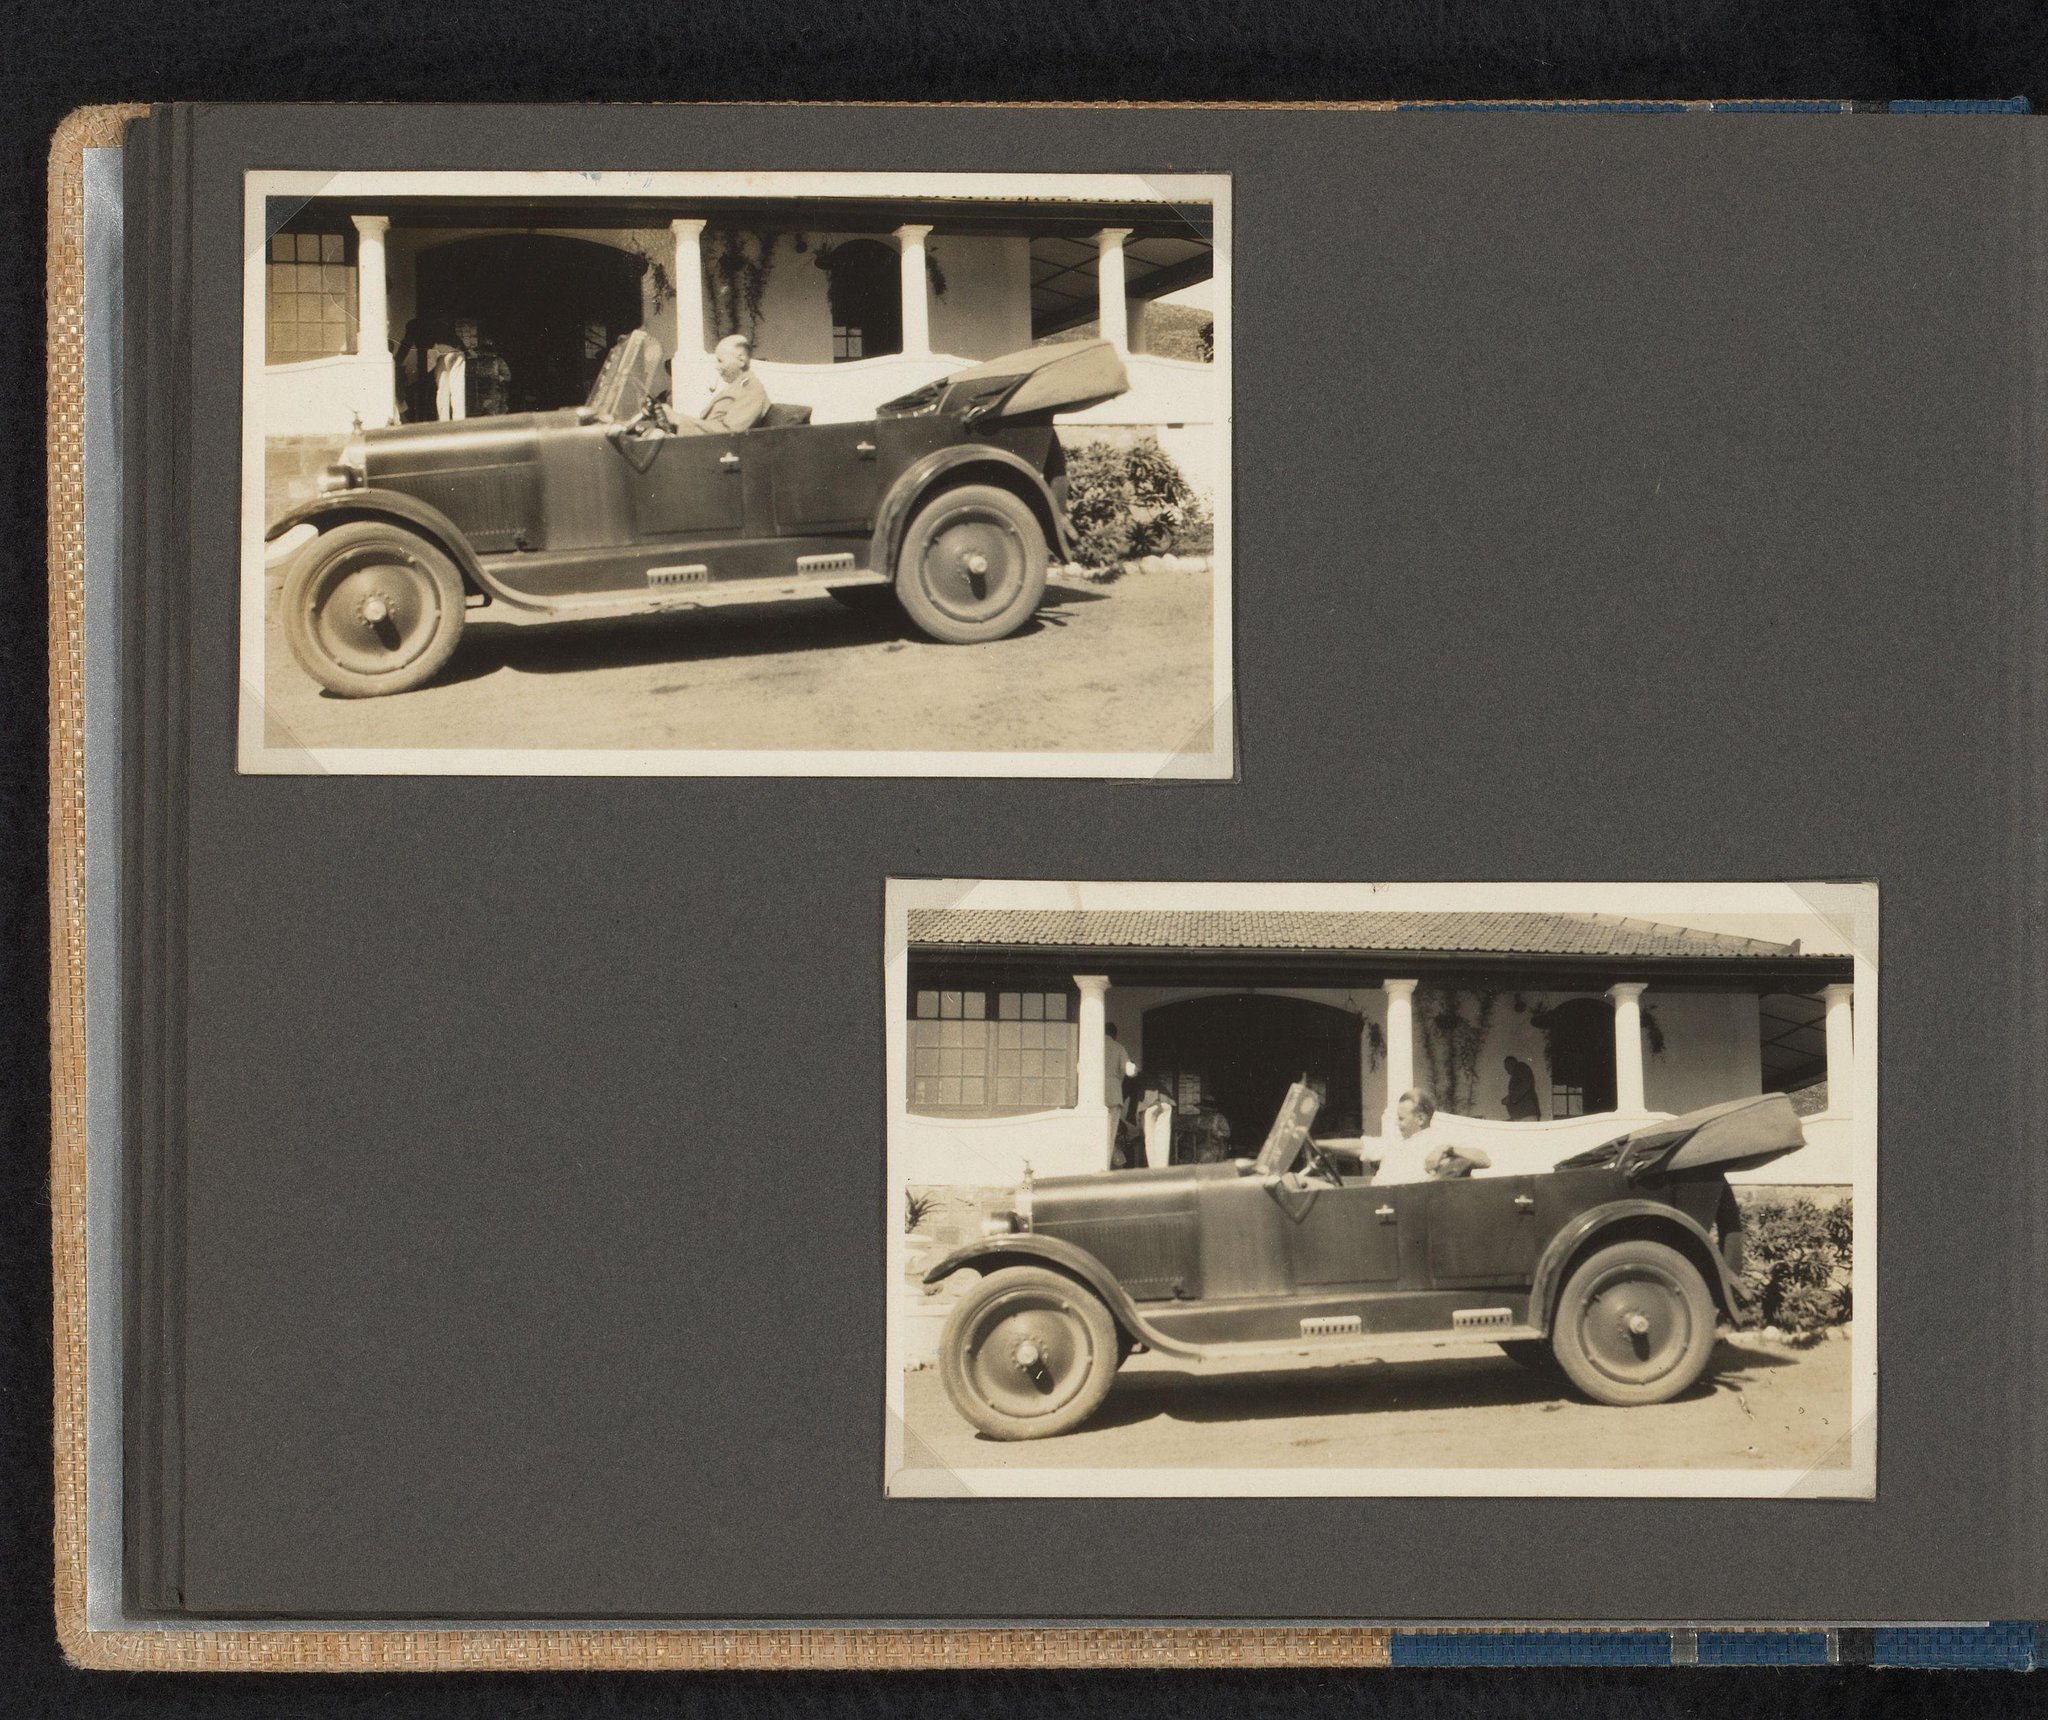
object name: photograph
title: Twee mannen poseren in een auto voor een landhuis in Zuid-Afrika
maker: karel frederik van den berg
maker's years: 1873-1948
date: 1925-1930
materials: paper, cardboard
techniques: gelatin silver print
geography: south africa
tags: automobile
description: Deze foto's zijn onderdeel van een album.